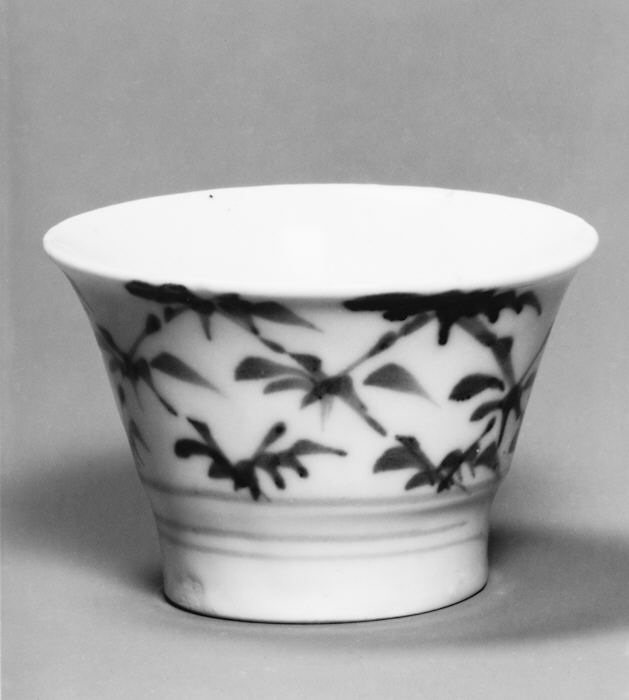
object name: soba cup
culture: japanese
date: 1667-1733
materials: porcelain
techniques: underglaze